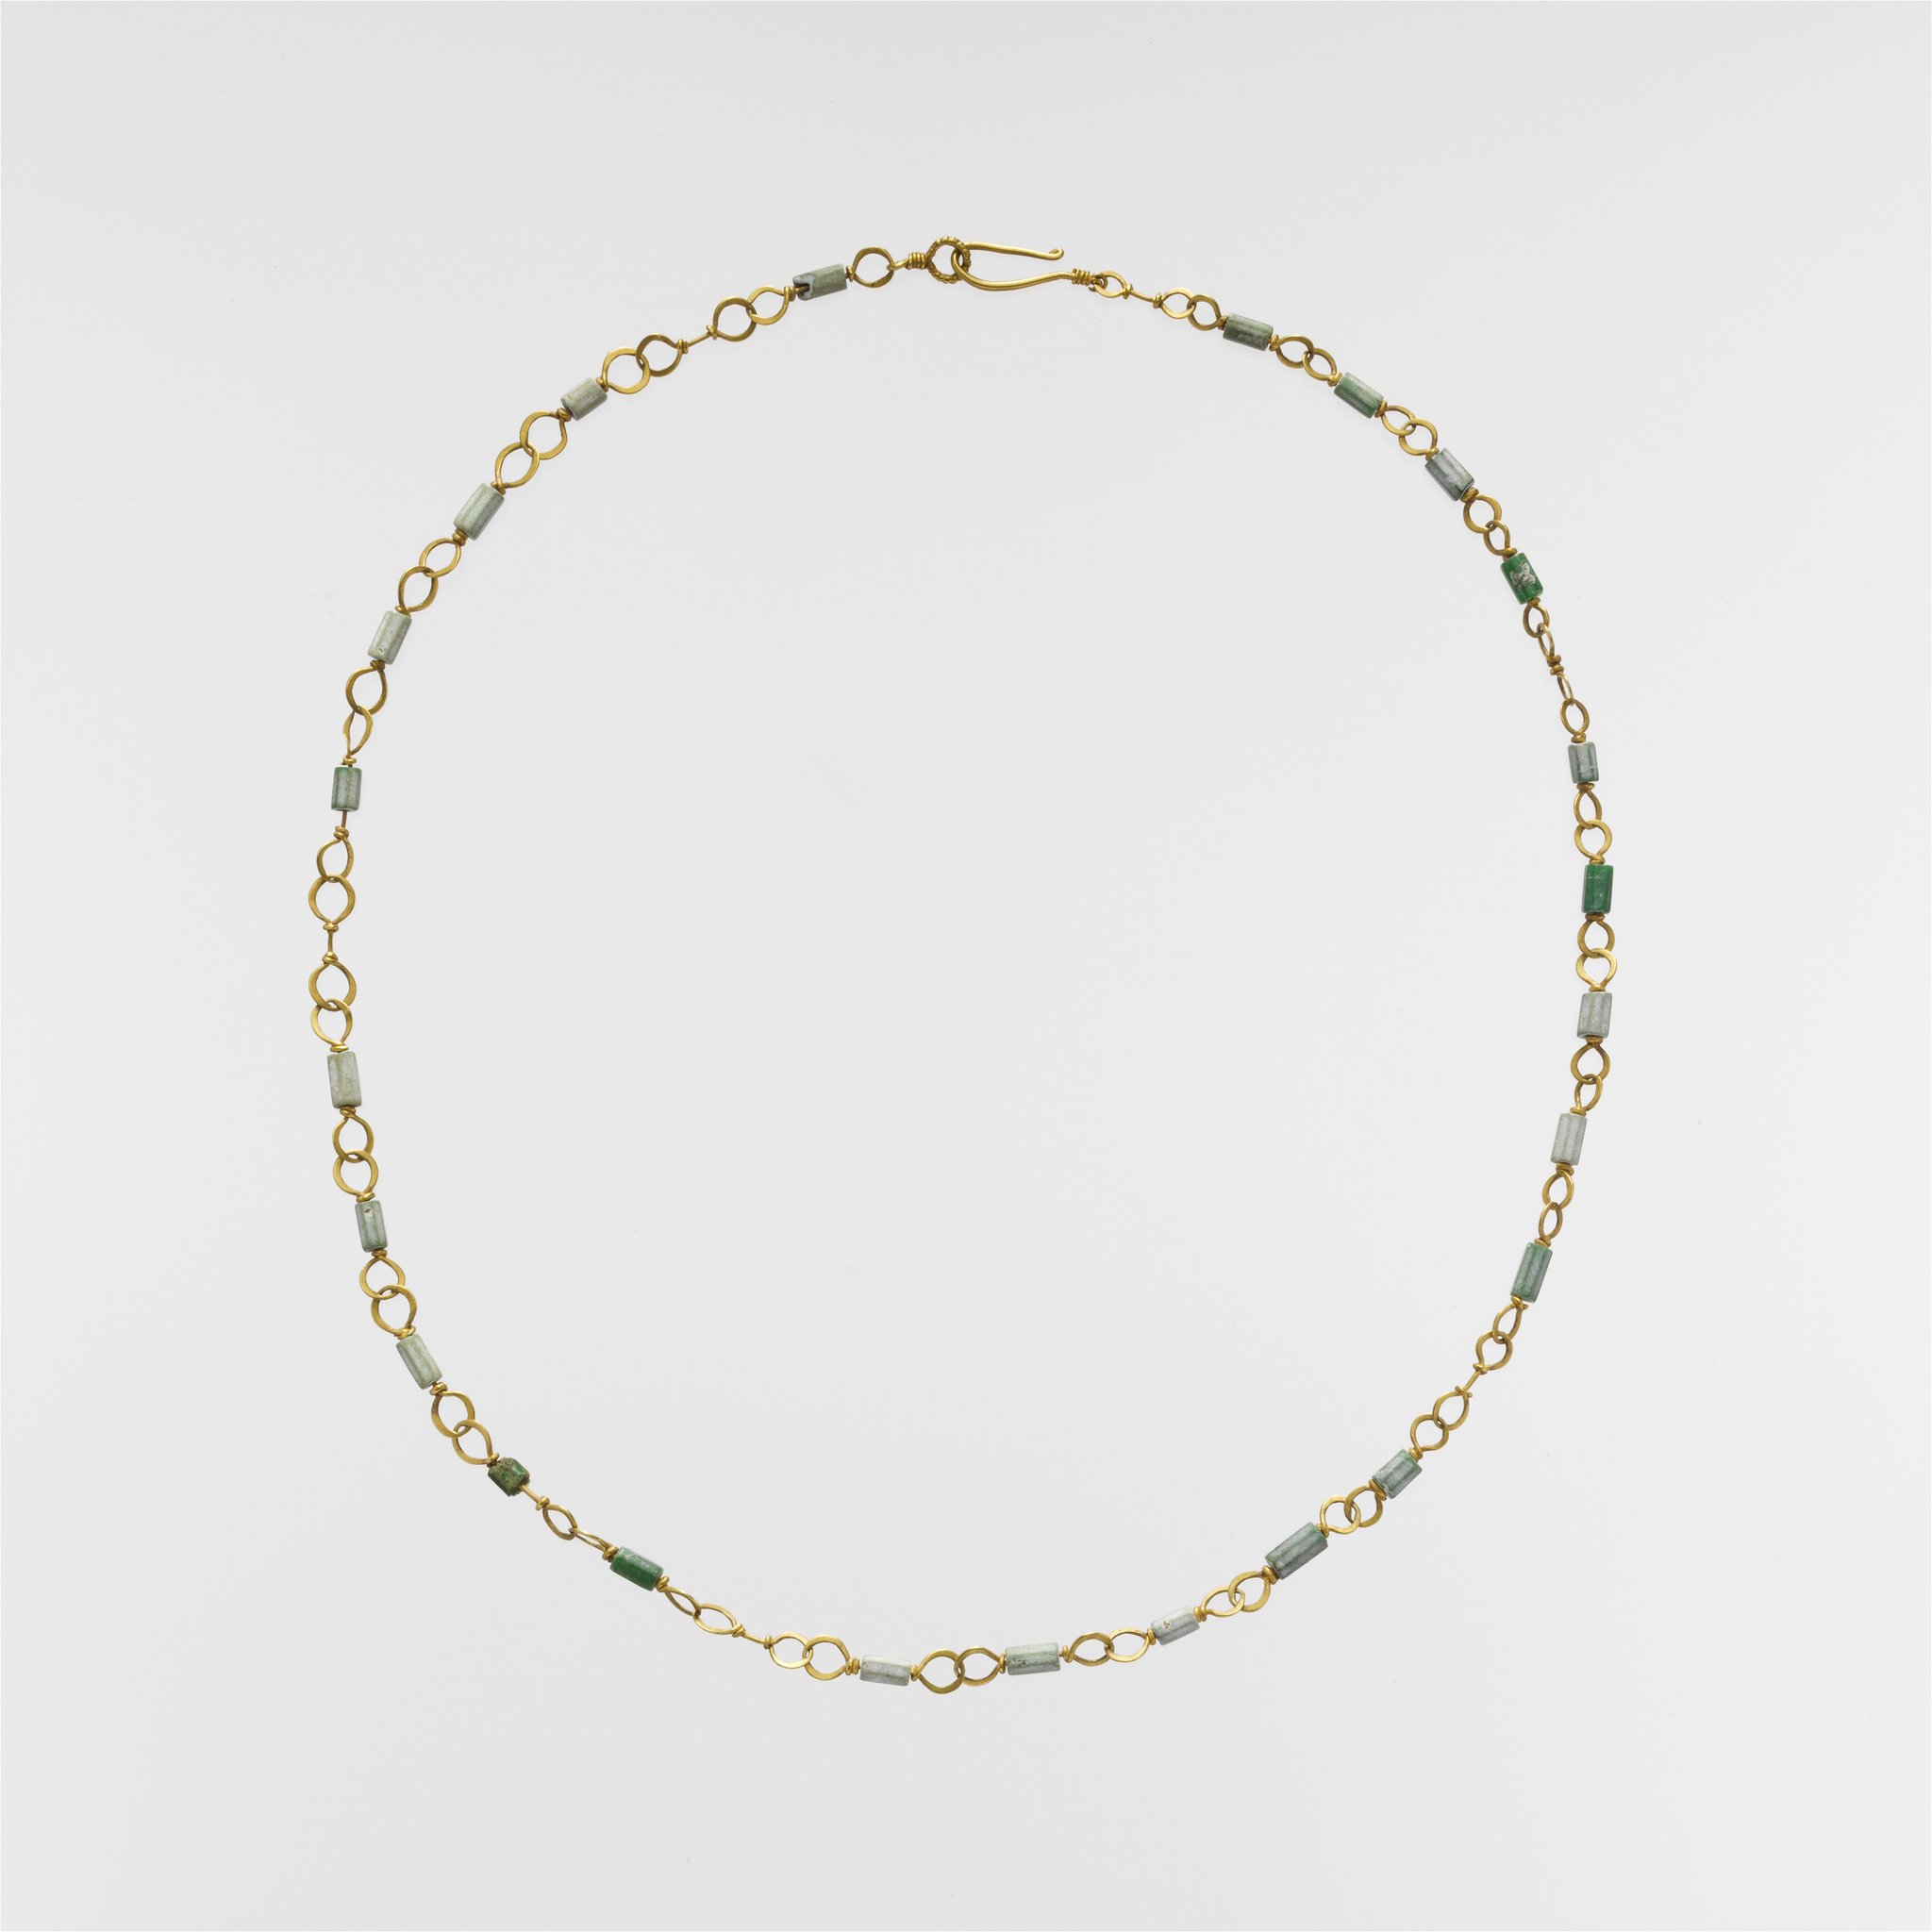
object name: necklace with gold chain and green bead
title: Gold necklace with emerald and variscite beads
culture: roman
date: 201-300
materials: gemstone, gold